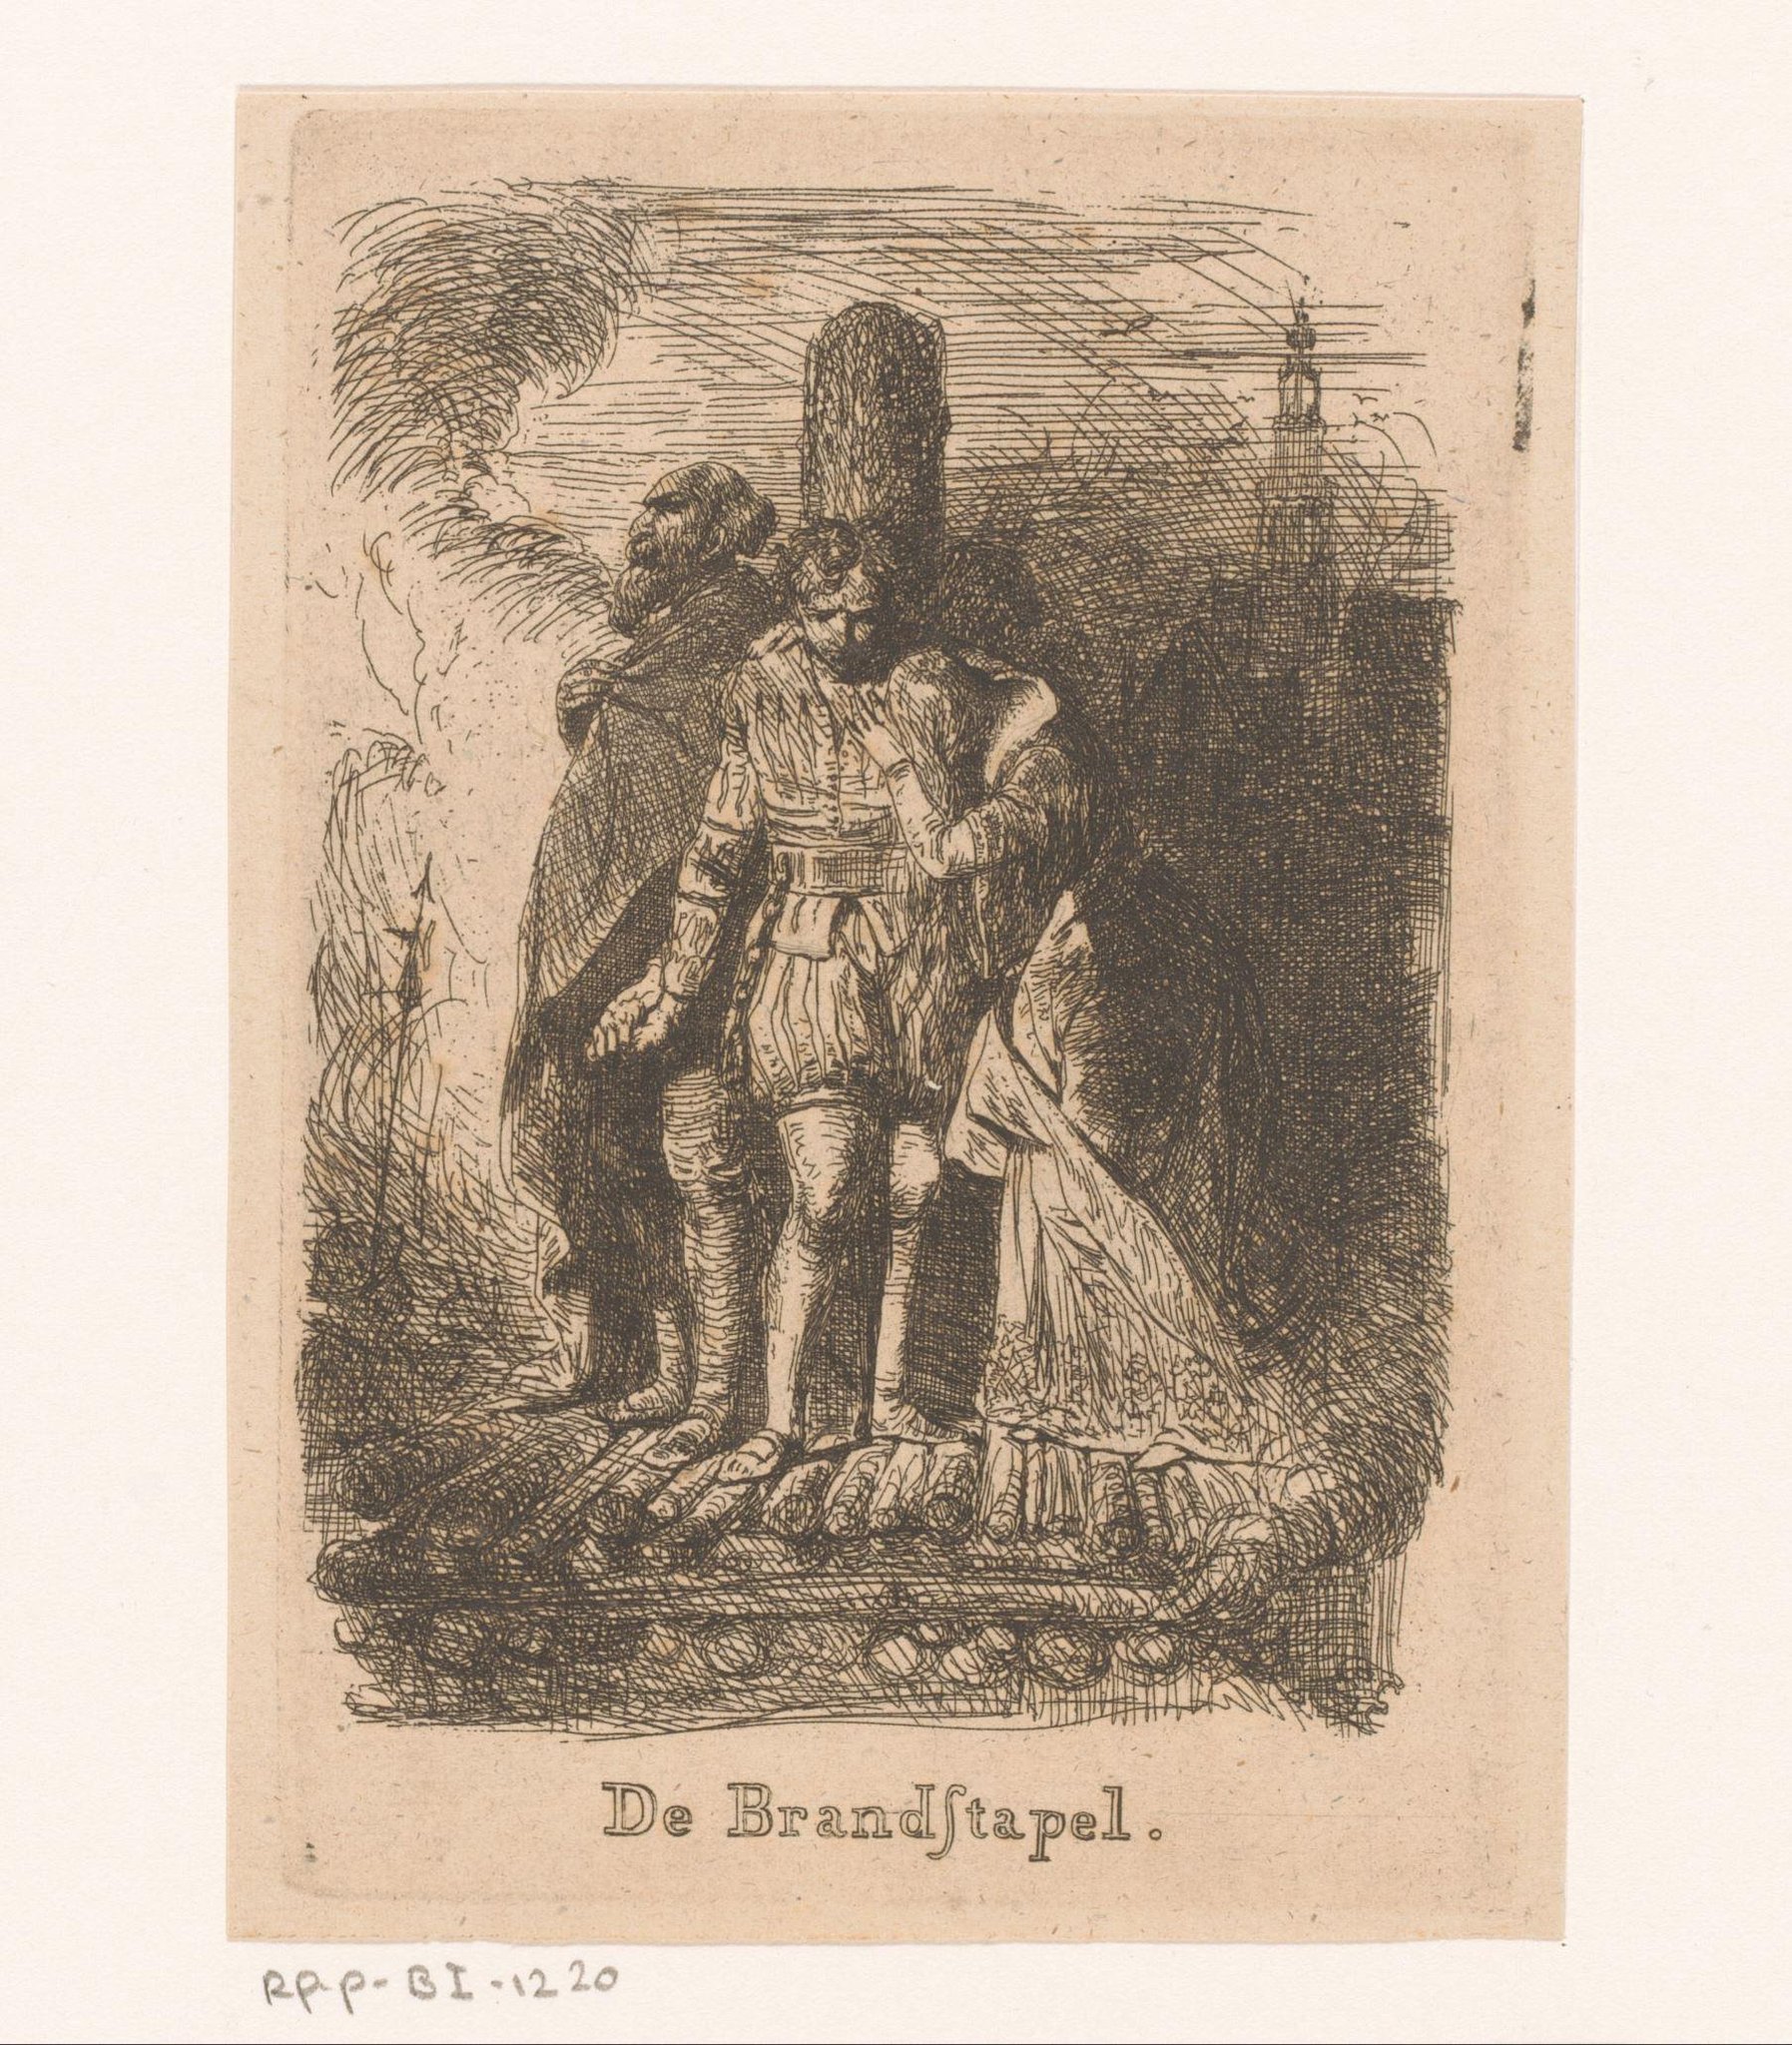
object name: print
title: Drie figuren op de brandstapel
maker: eugène françois de block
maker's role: draughtsman, painter, print maker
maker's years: 1812-1893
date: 1822-1893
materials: paper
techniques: etching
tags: violent death by burning at the stake; pyre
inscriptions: collector's mark: Lugt 2228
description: Drie figuren op de brandstapel met een kerktoren op de achtergrond.